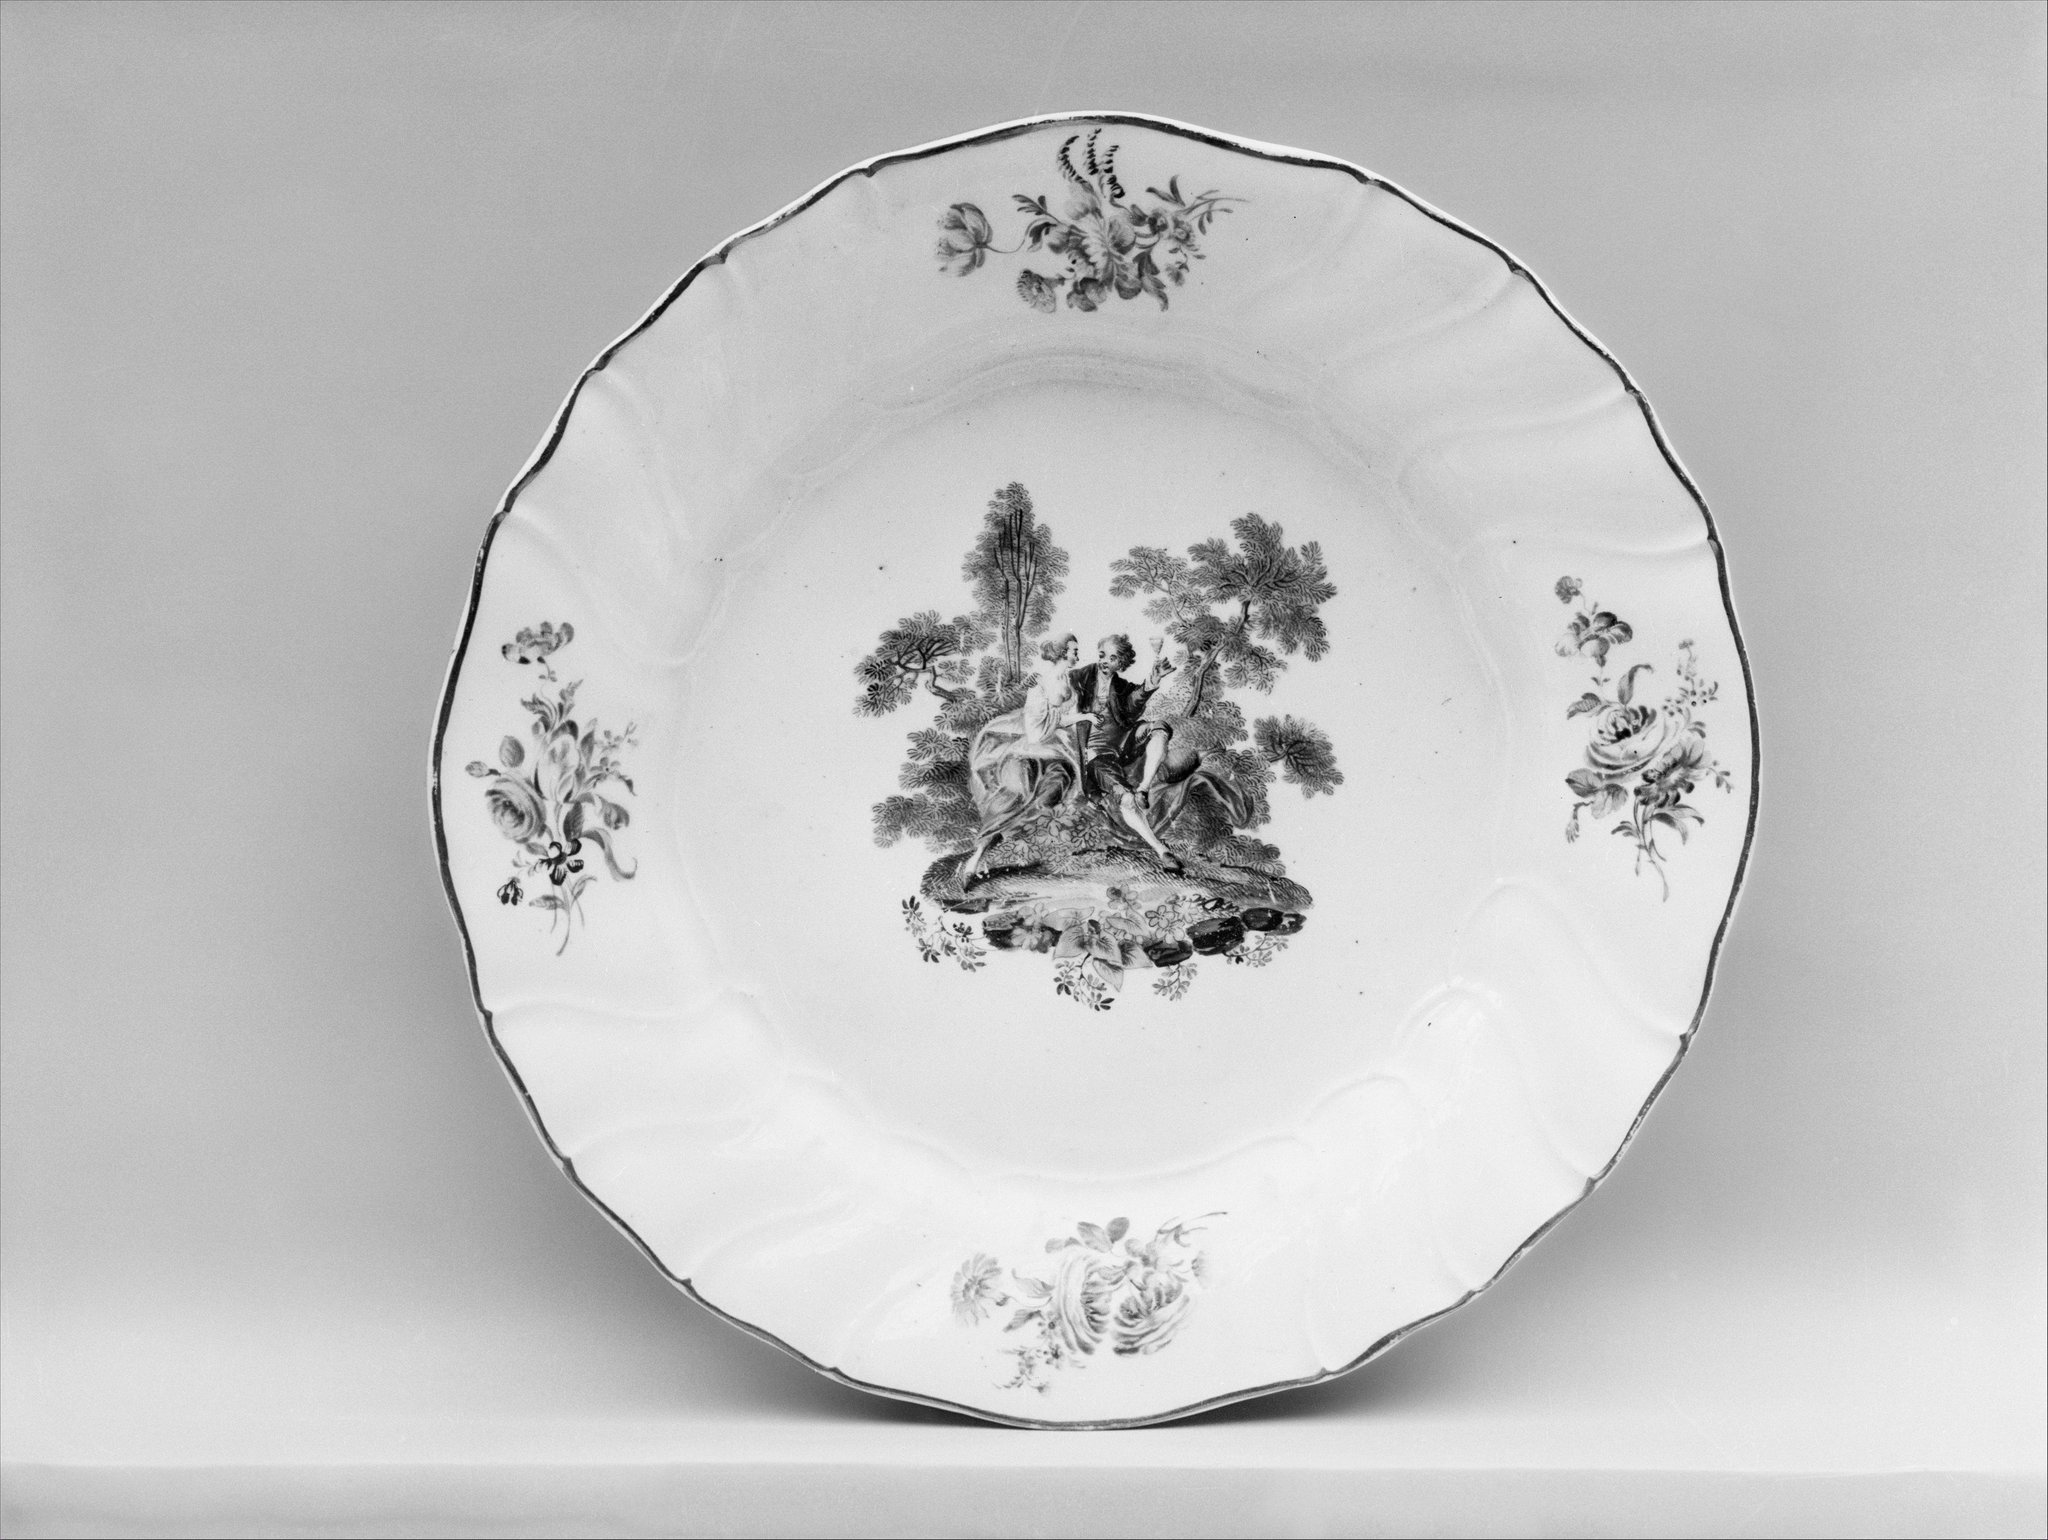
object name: plate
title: Plate (one of a pair)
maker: tournai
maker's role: factory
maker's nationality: belgian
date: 1762-1770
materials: soft paste porcelain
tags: men,women,flowers,trees